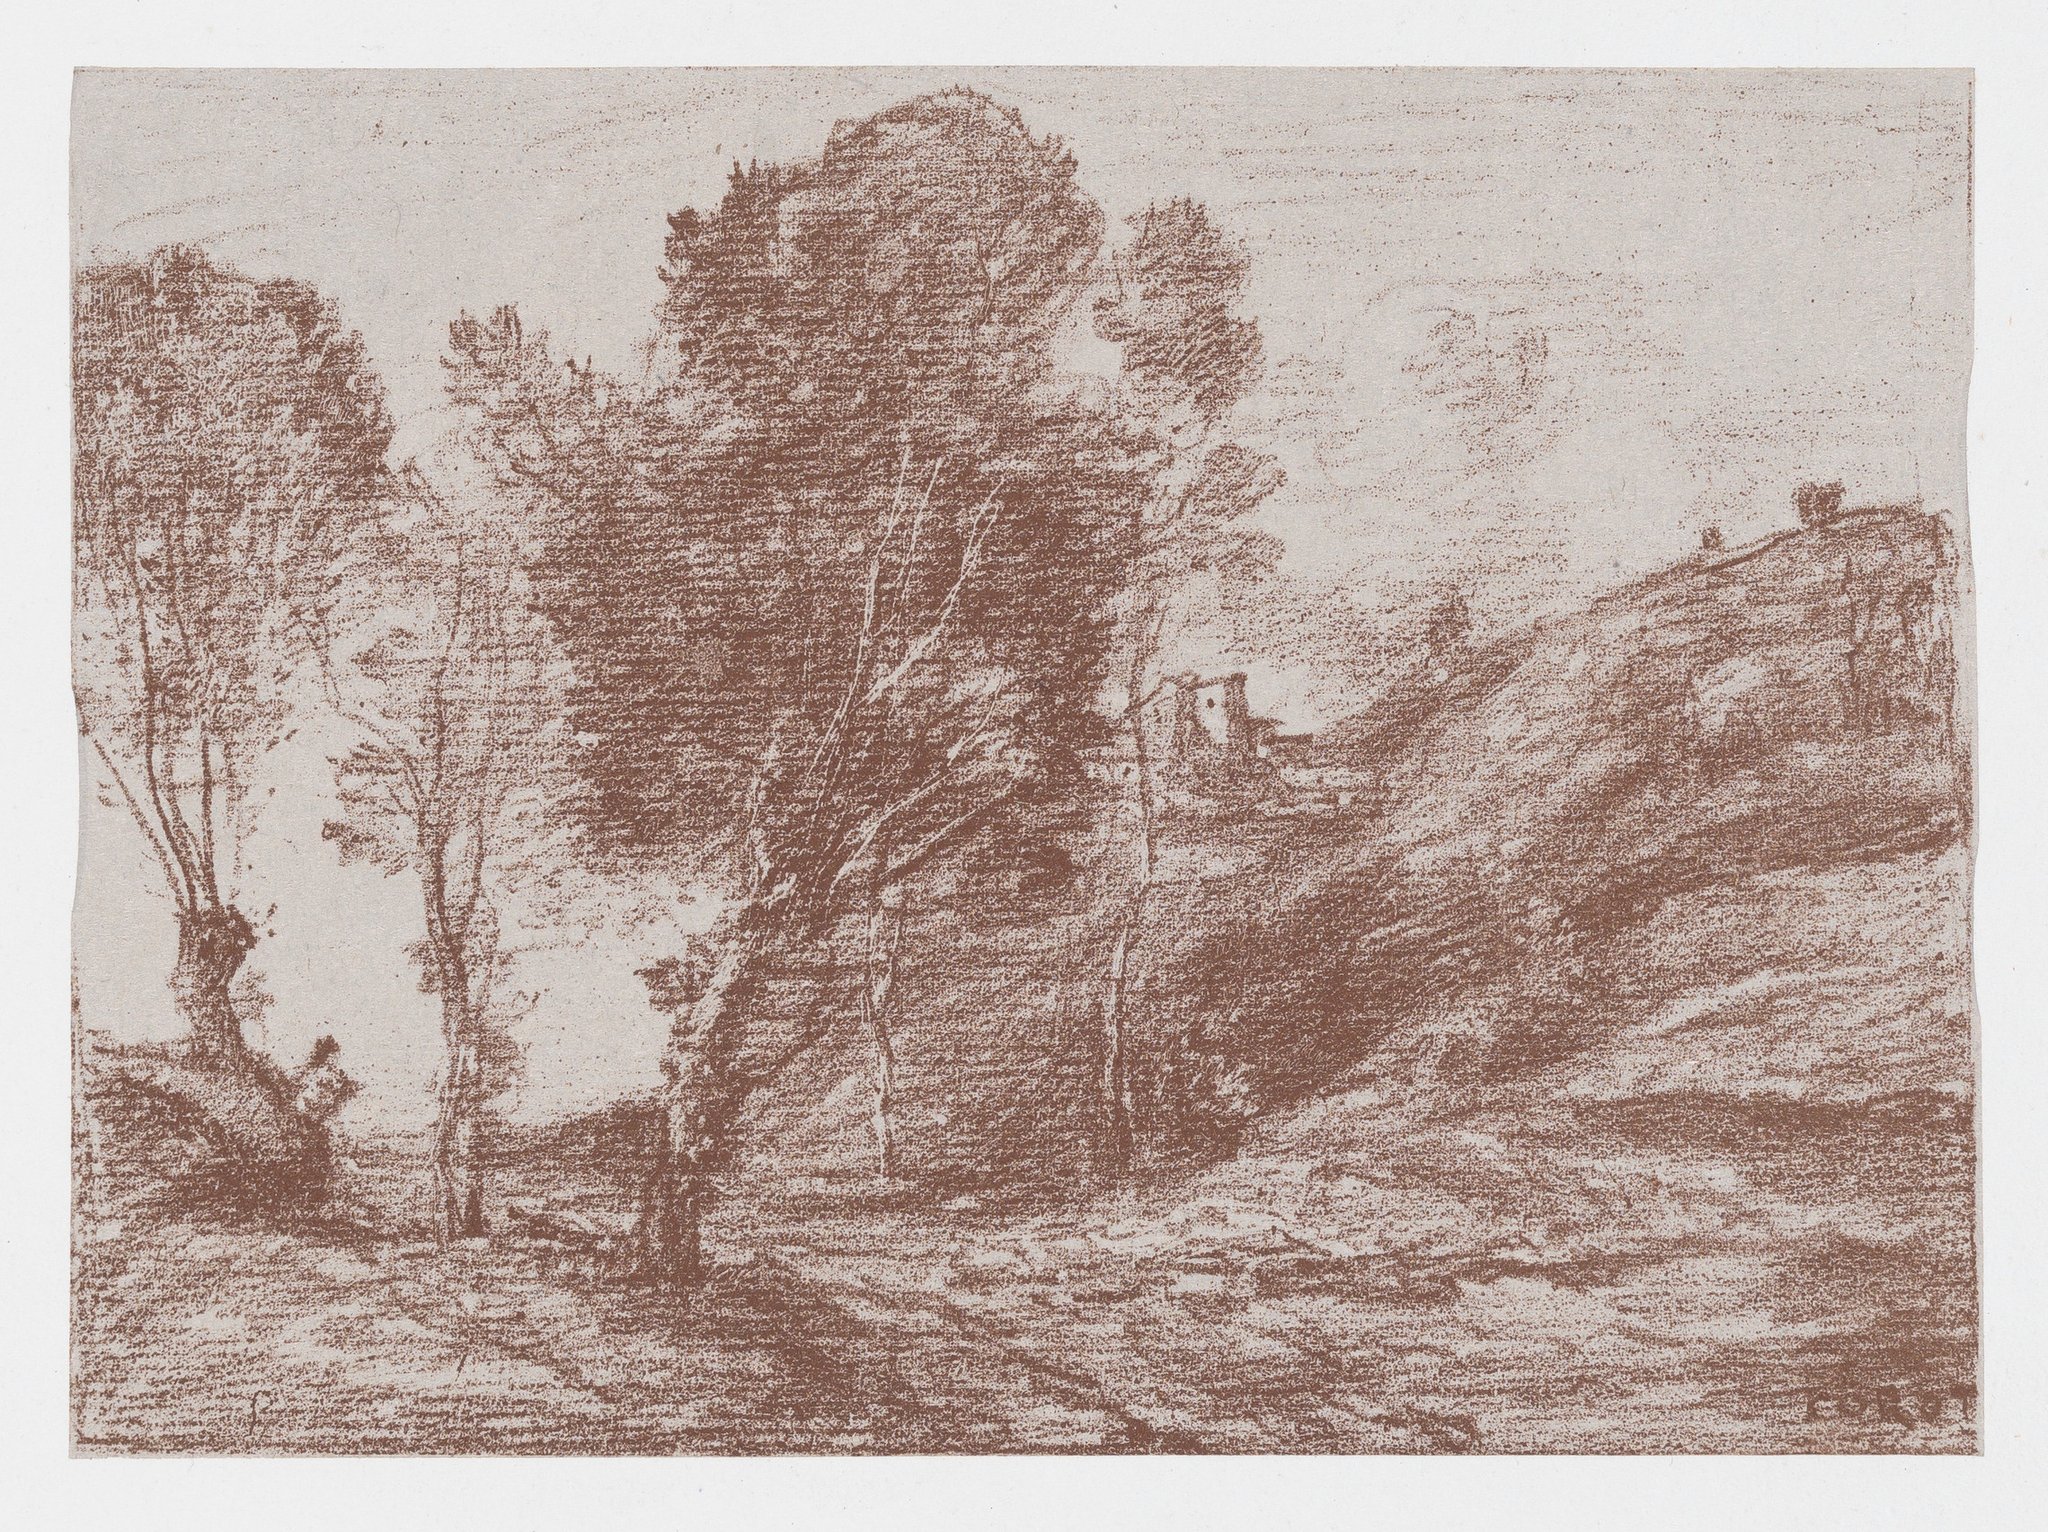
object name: print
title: Souvenir of Italy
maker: jean-baptiste-camille corot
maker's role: artist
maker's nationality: french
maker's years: 1796-1875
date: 1871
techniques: lithography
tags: landscapes,trees